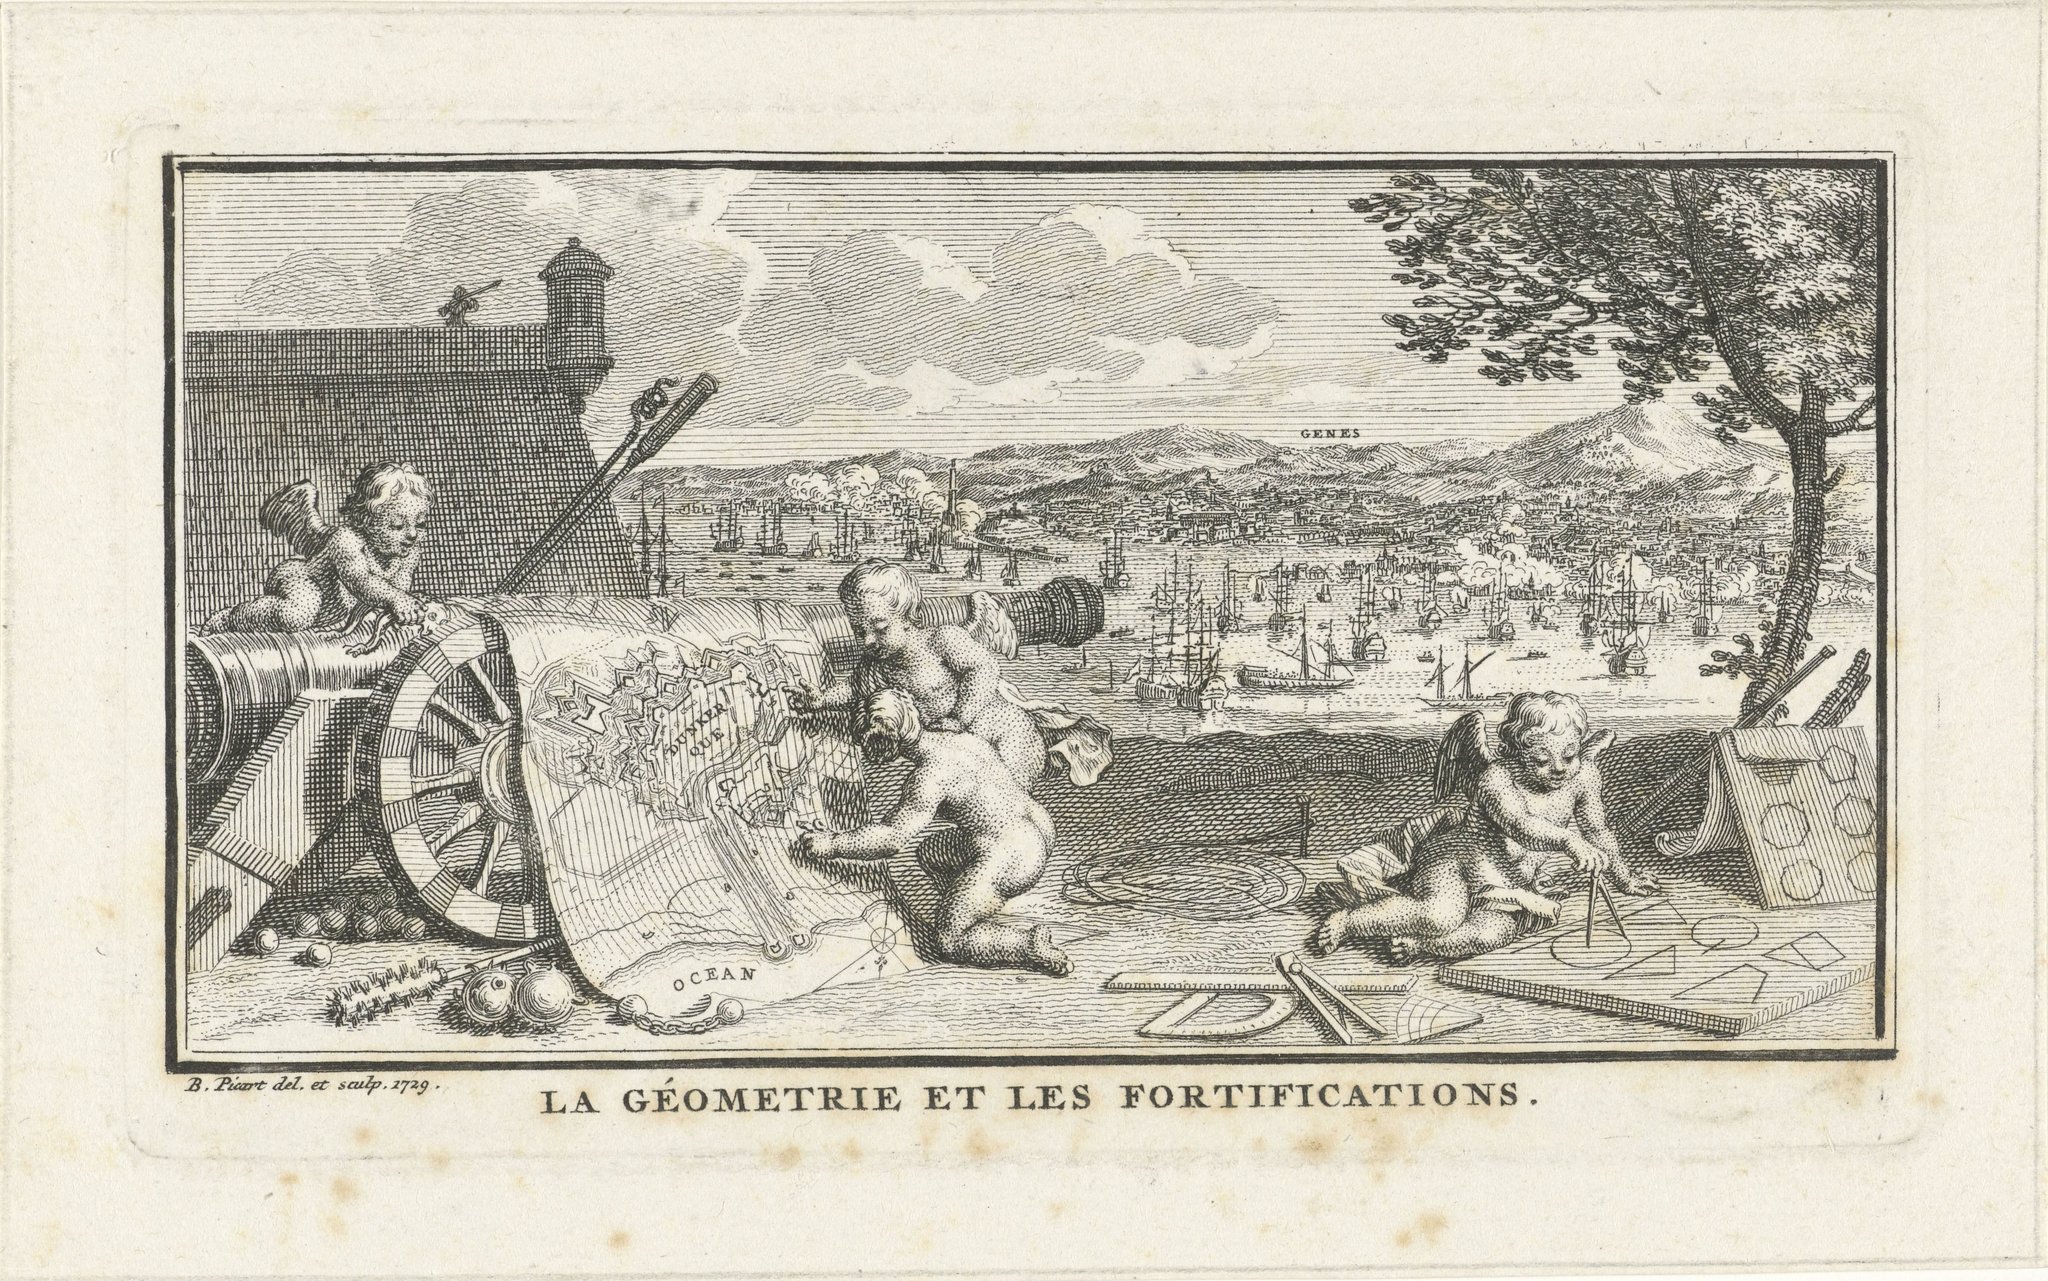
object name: print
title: La Géometrie et les Fortifications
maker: bernard picart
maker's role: draughtsman, print maker, publisher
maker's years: 1673-1733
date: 1729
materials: paper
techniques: engraving, etching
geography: amsterdam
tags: planimetry, geometry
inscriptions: collector's mark: Lugt 240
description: Putti bestuderen een landkaart bij een kanon. Een andere putto tekent met een passer diverse geometrische figuren. Op de achtergrond een gezicht op de Italiaanse havenstad Genua.